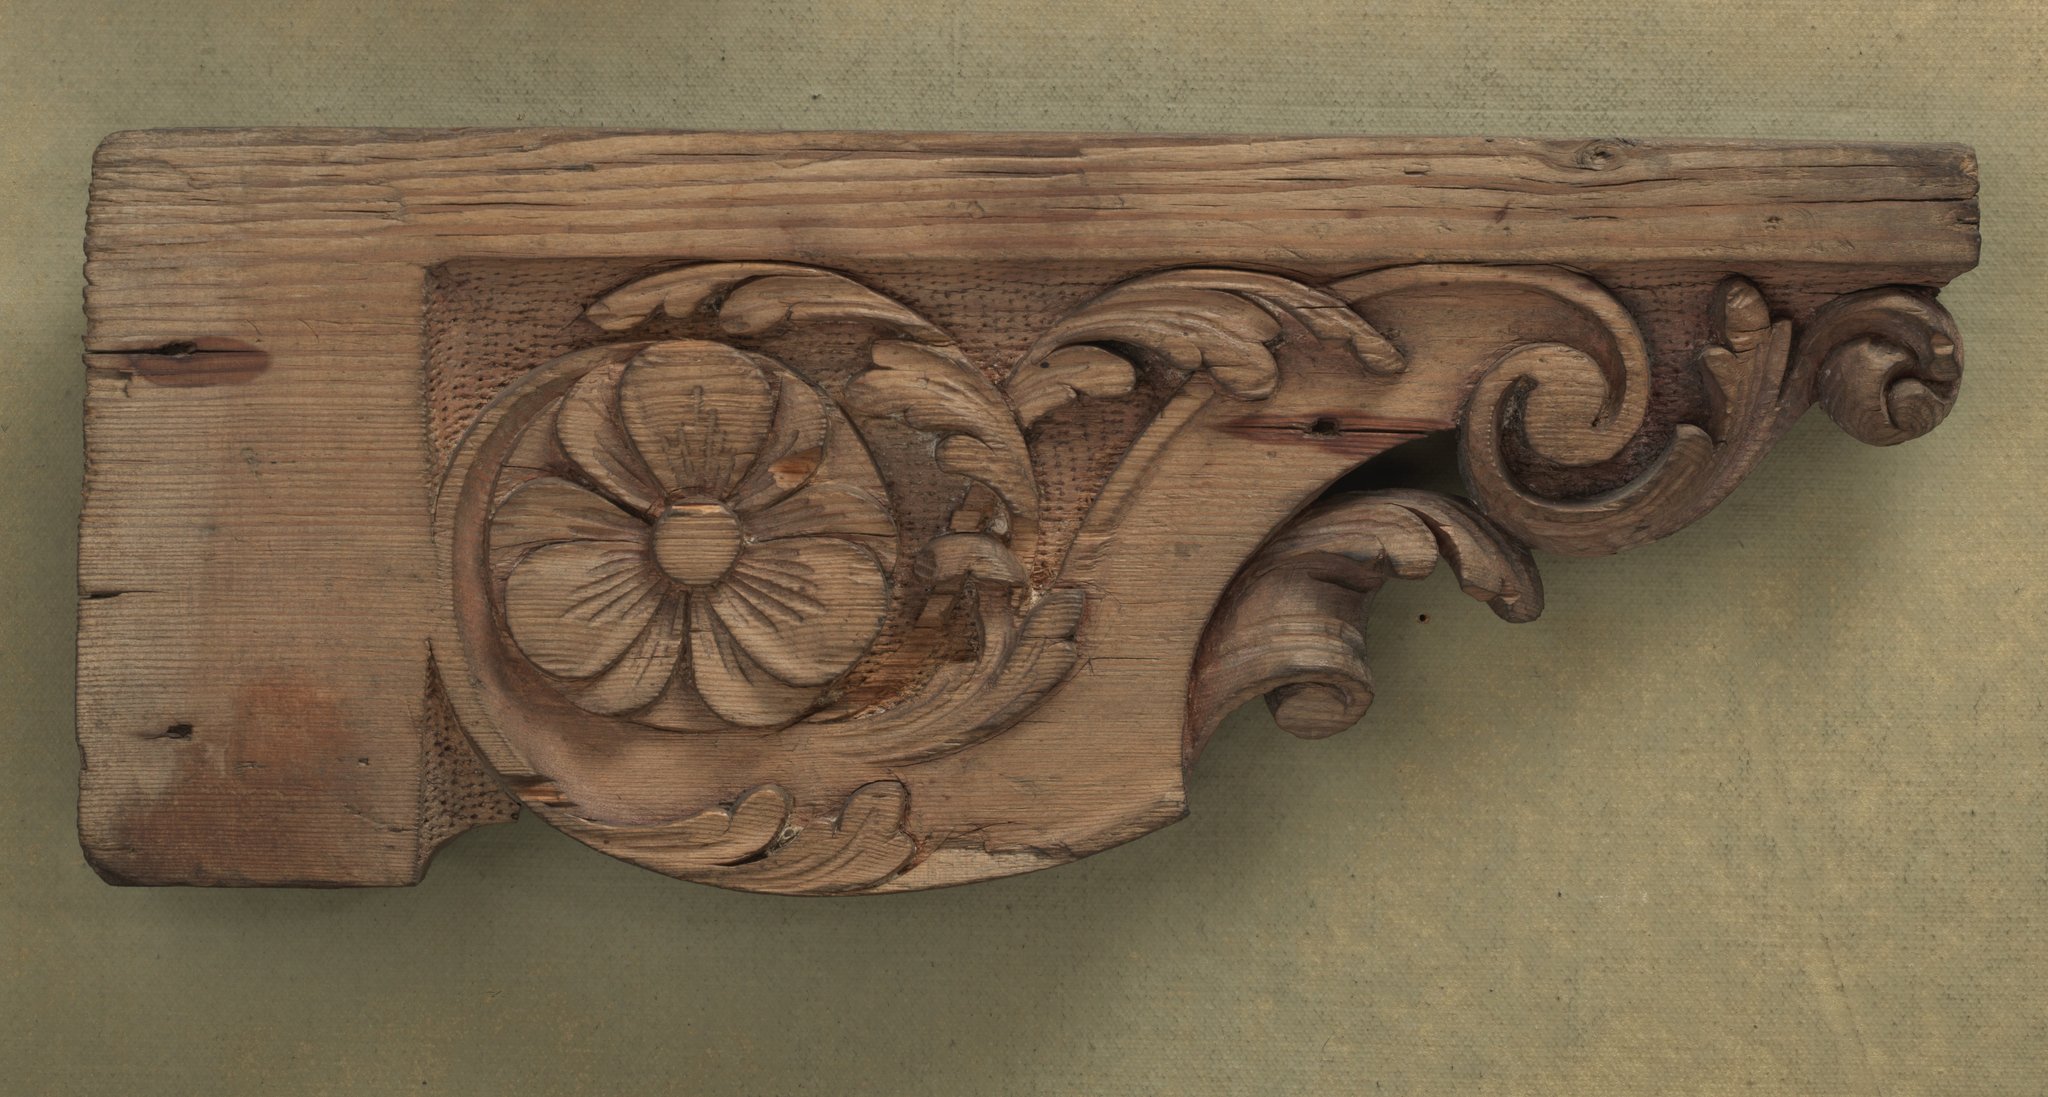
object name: bracket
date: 1701-1800